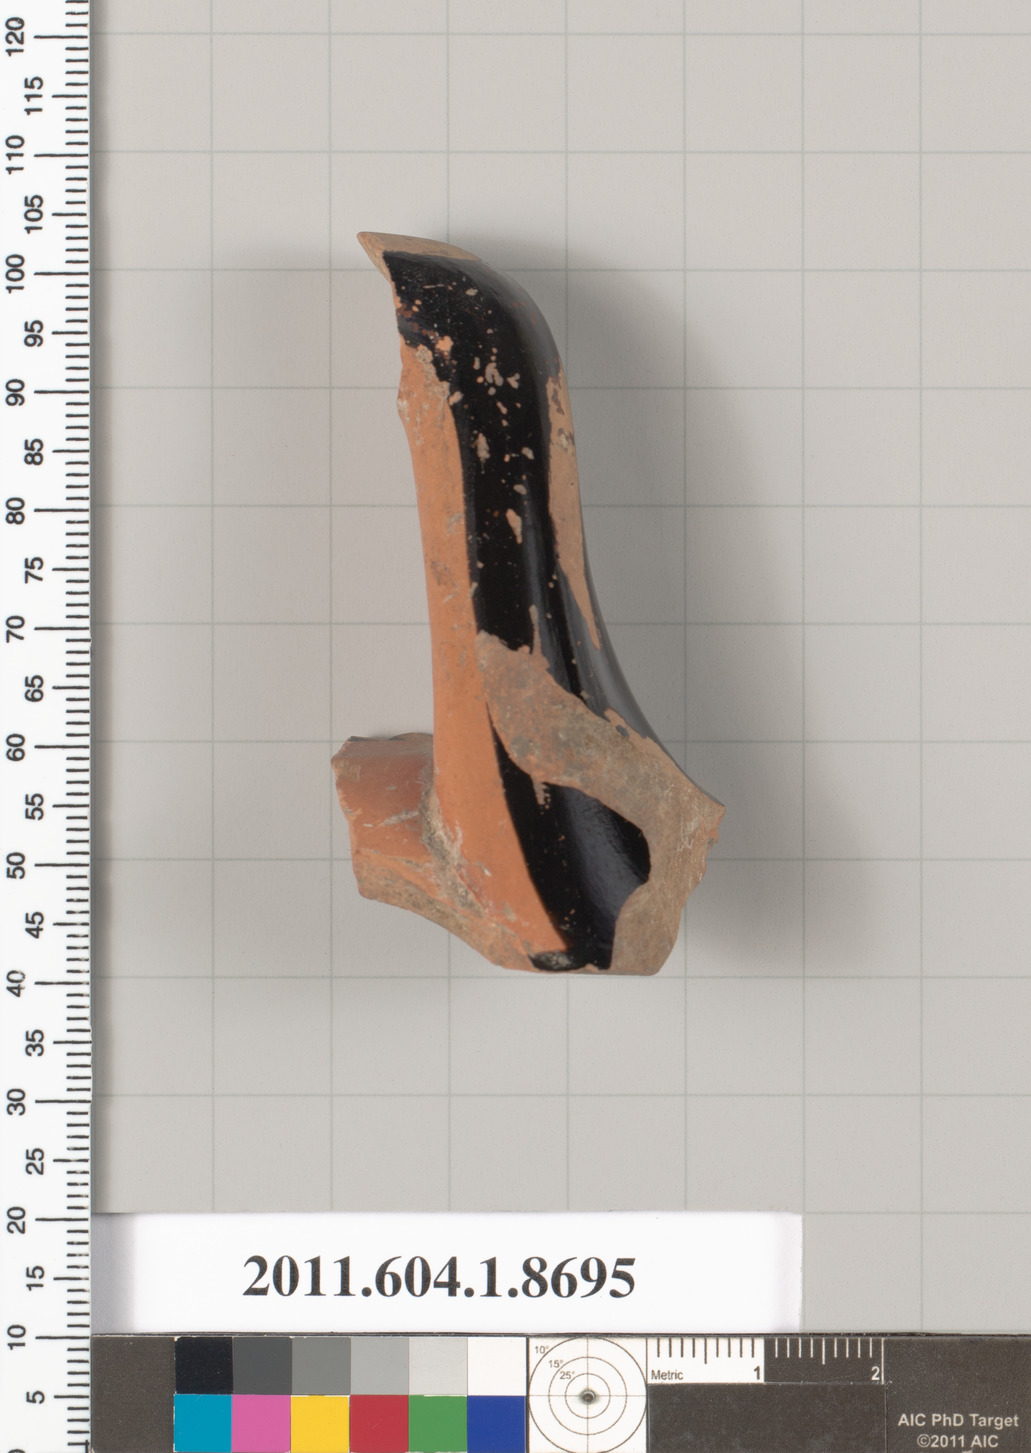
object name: kylix fragment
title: Terracotta fragment of a stemless kylix (drinking cup)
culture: greek, attic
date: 470-450 BCE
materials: terracotta